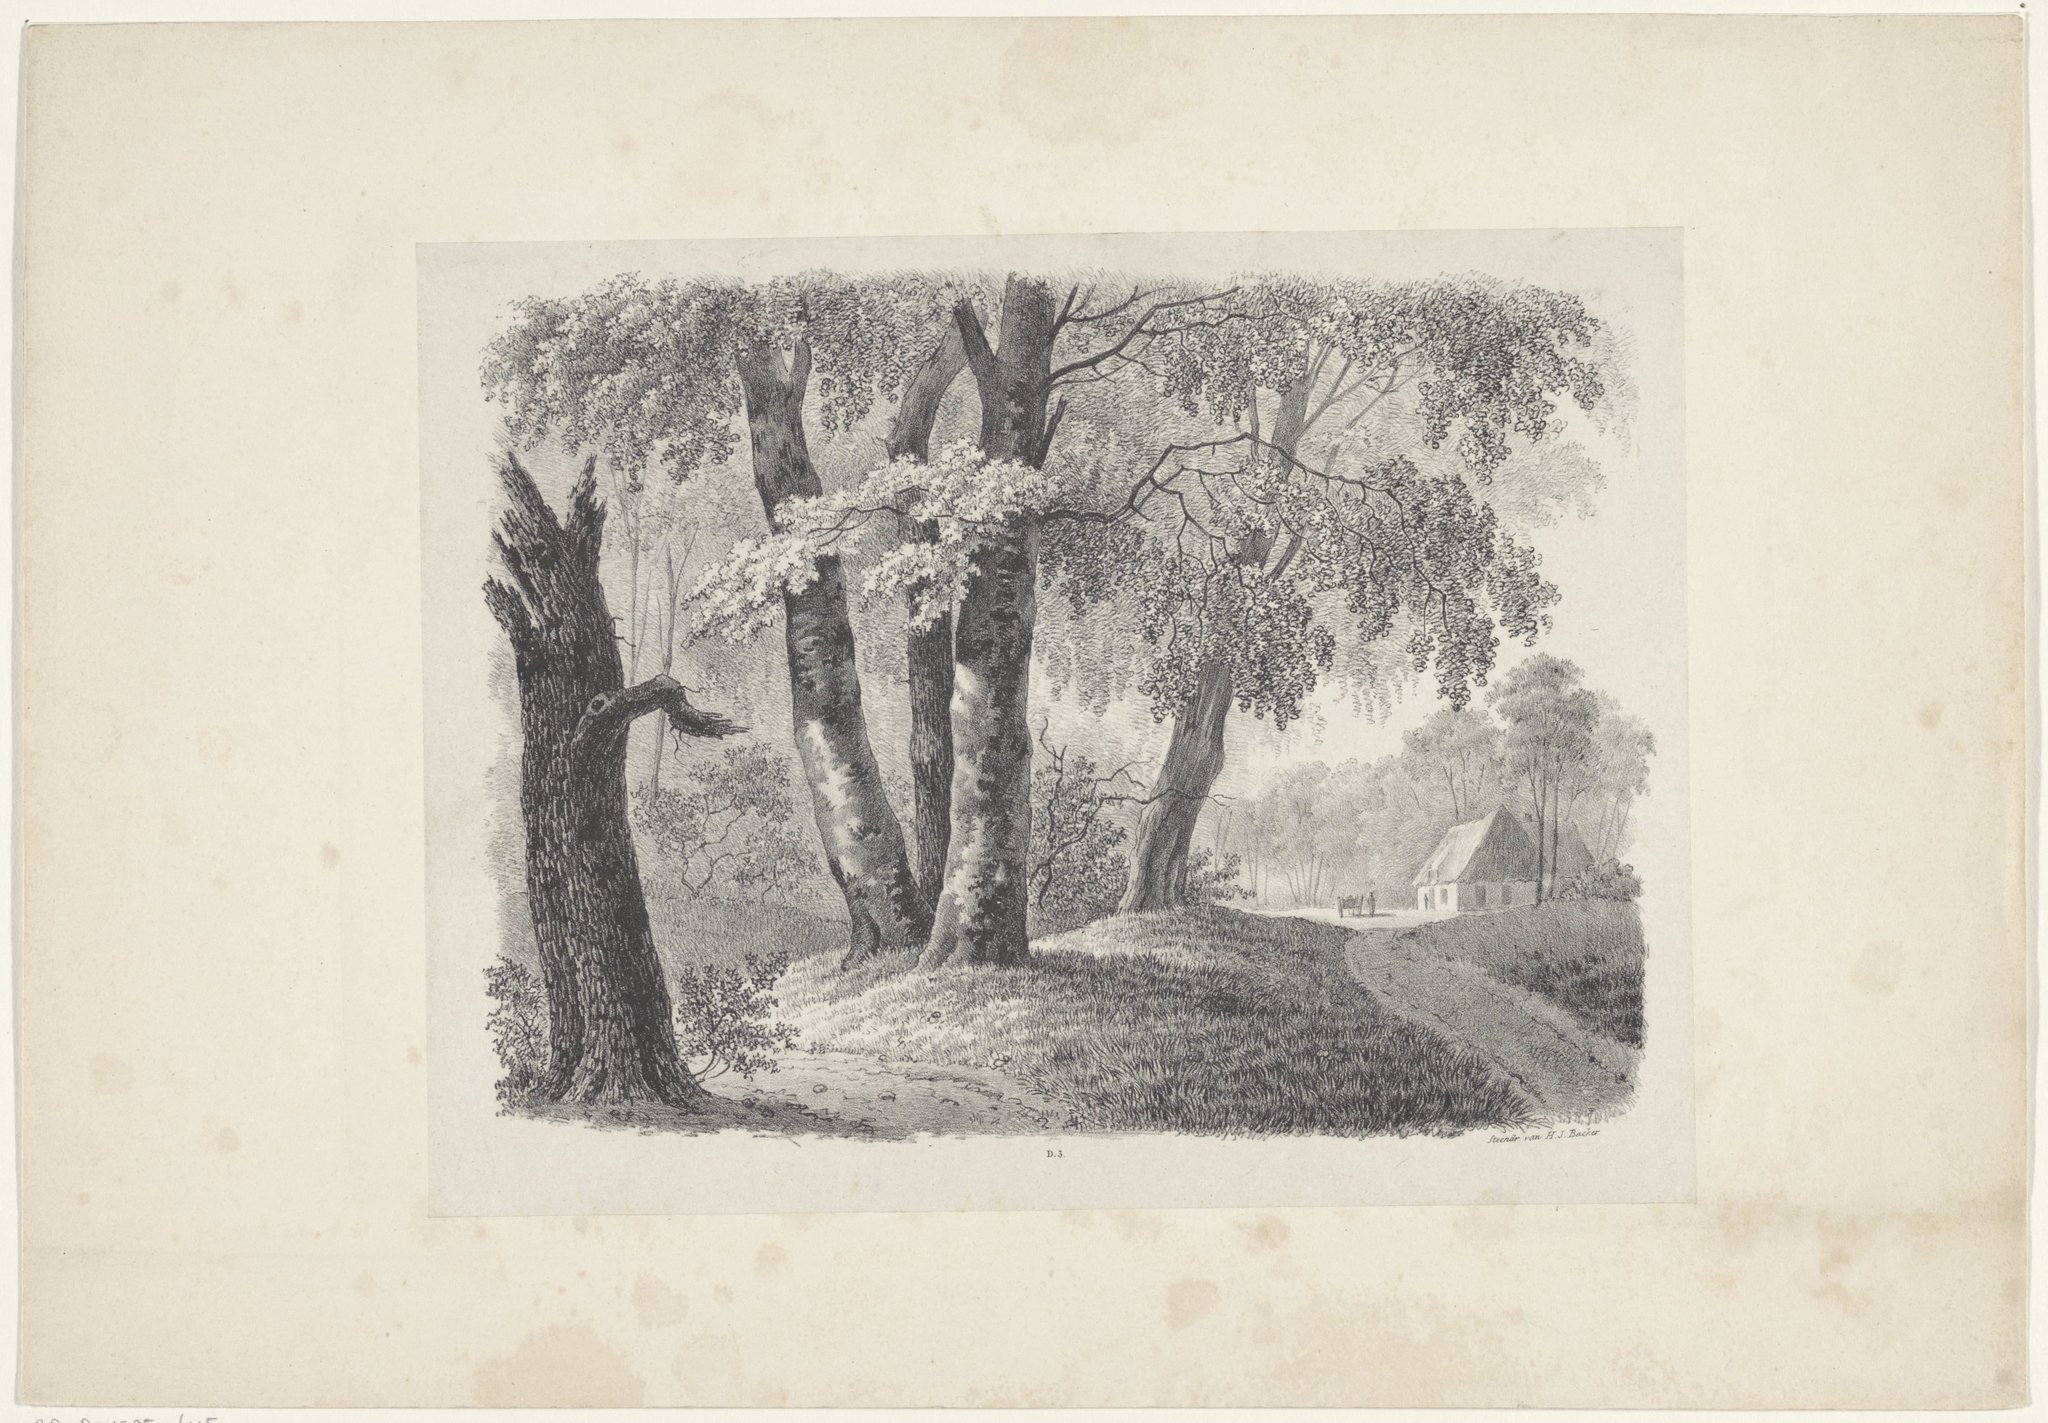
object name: print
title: Bos en een hoeve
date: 1822-1845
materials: paper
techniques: lithograph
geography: dordrecht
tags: forest, wood, forest path or lane, farm or solitary house in landscape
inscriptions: collector's mark: Lugt 2228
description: Twee landwegen lopen door en langs een bos, verderop een hoeve. Op het erf staat een kar met een figuur ernaast.